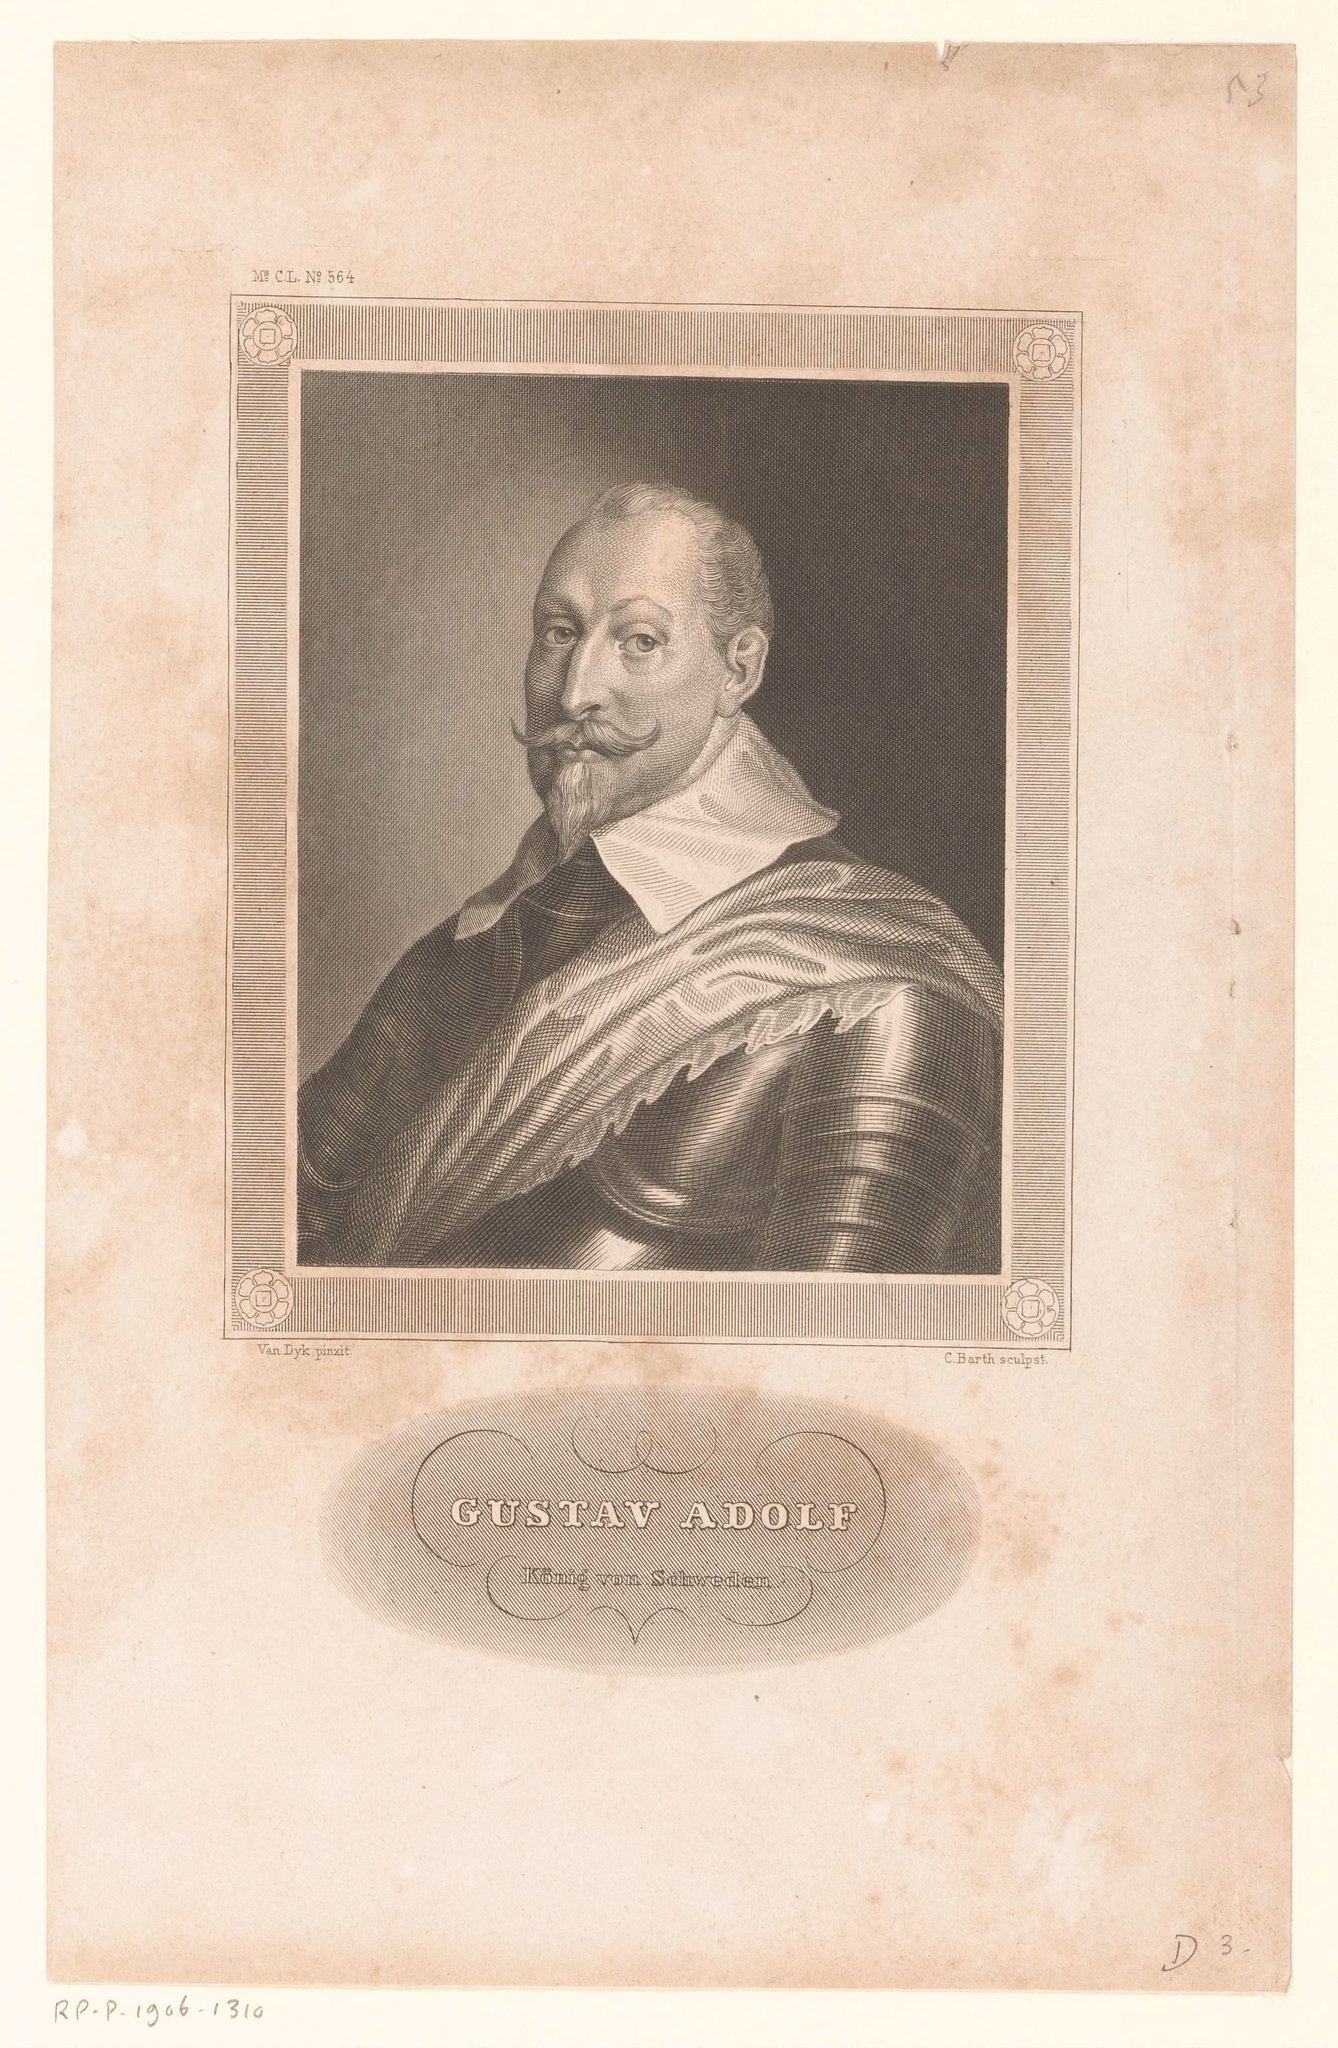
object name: print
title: Gustaaf II Adolf van Zweden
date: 1828-1853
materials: paper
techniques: engraving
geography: hildburghausen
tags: historical persons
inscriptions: collector's mark: Lugt 2228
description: Prent afkomstig uit: Meyer, Joseph. Das große Conversations-Lexikon für die gebildeten Stände.